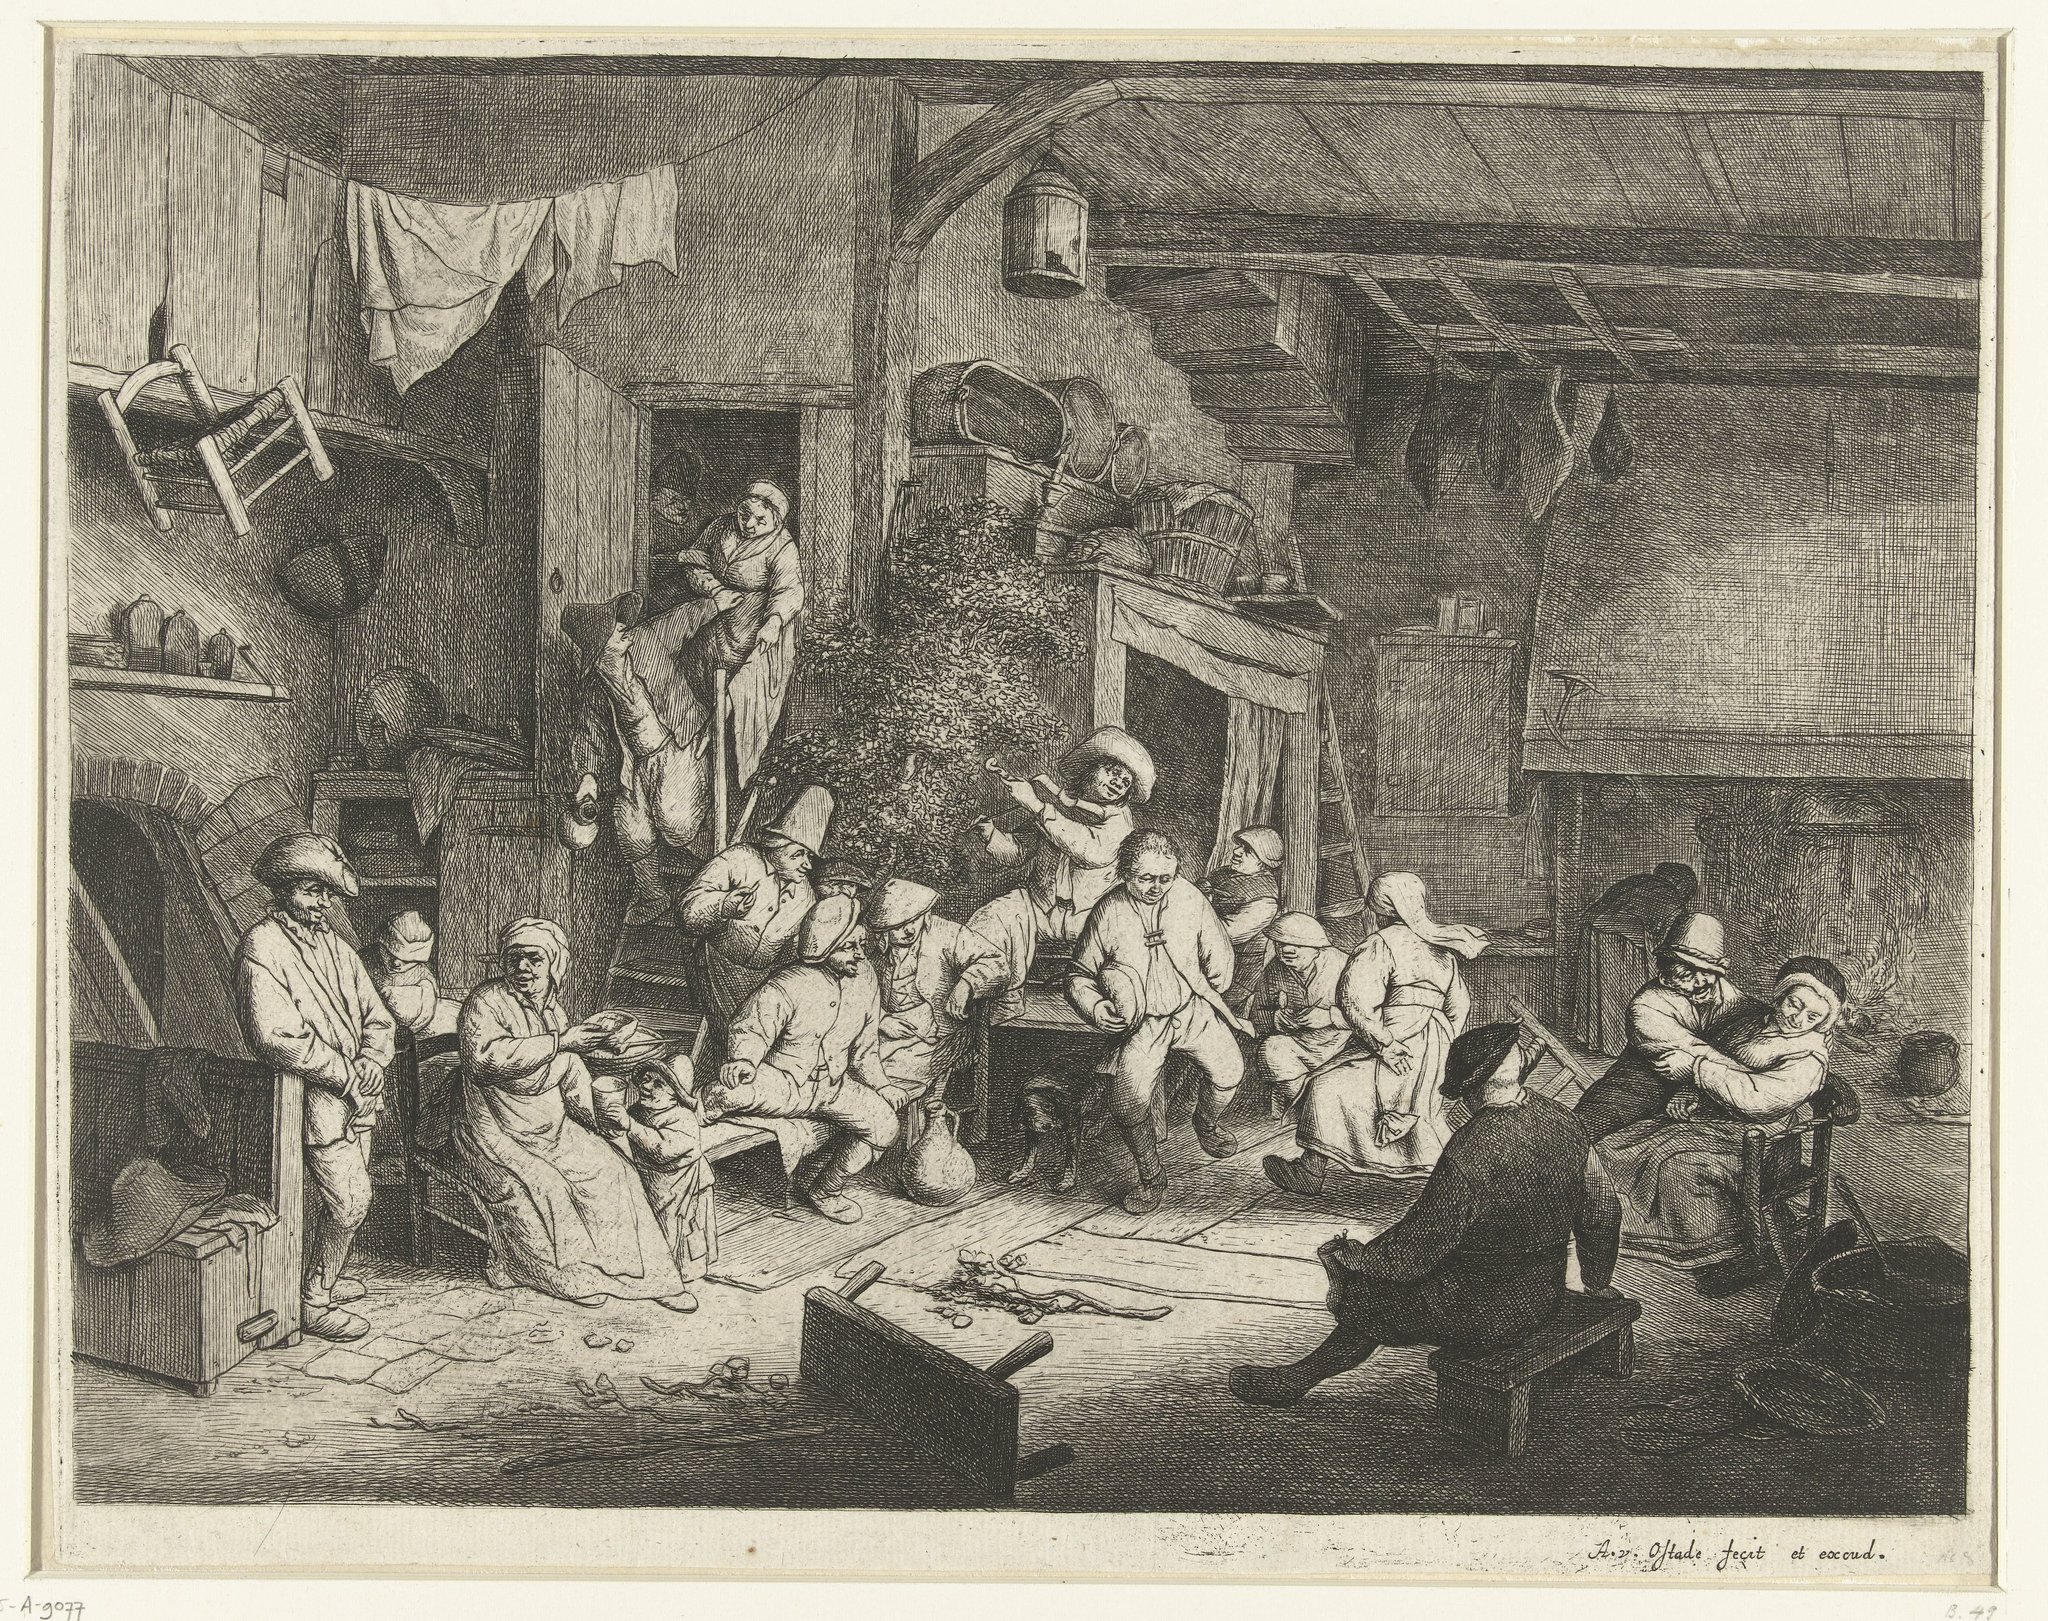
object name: print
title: Dans in de herberg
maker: adriaen van ostade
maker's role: draughtsman, painter, print maker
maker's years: 1610-1685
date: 1650-1654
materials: paper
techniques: etching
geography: haarlem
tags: inn, coffee-house, public house, etc., one pair dancing; man and woman dancing as a couple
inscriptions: collector's mark: Lugt 2228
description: Een groep mensen in een rommelige herberg, te midden van hen dansen een man en een vrouw op de muziek van een vedelspeler. Geheel rechts omhelst een man een zittende vrouw. Drie personen komen de herberg binnen via een trap.